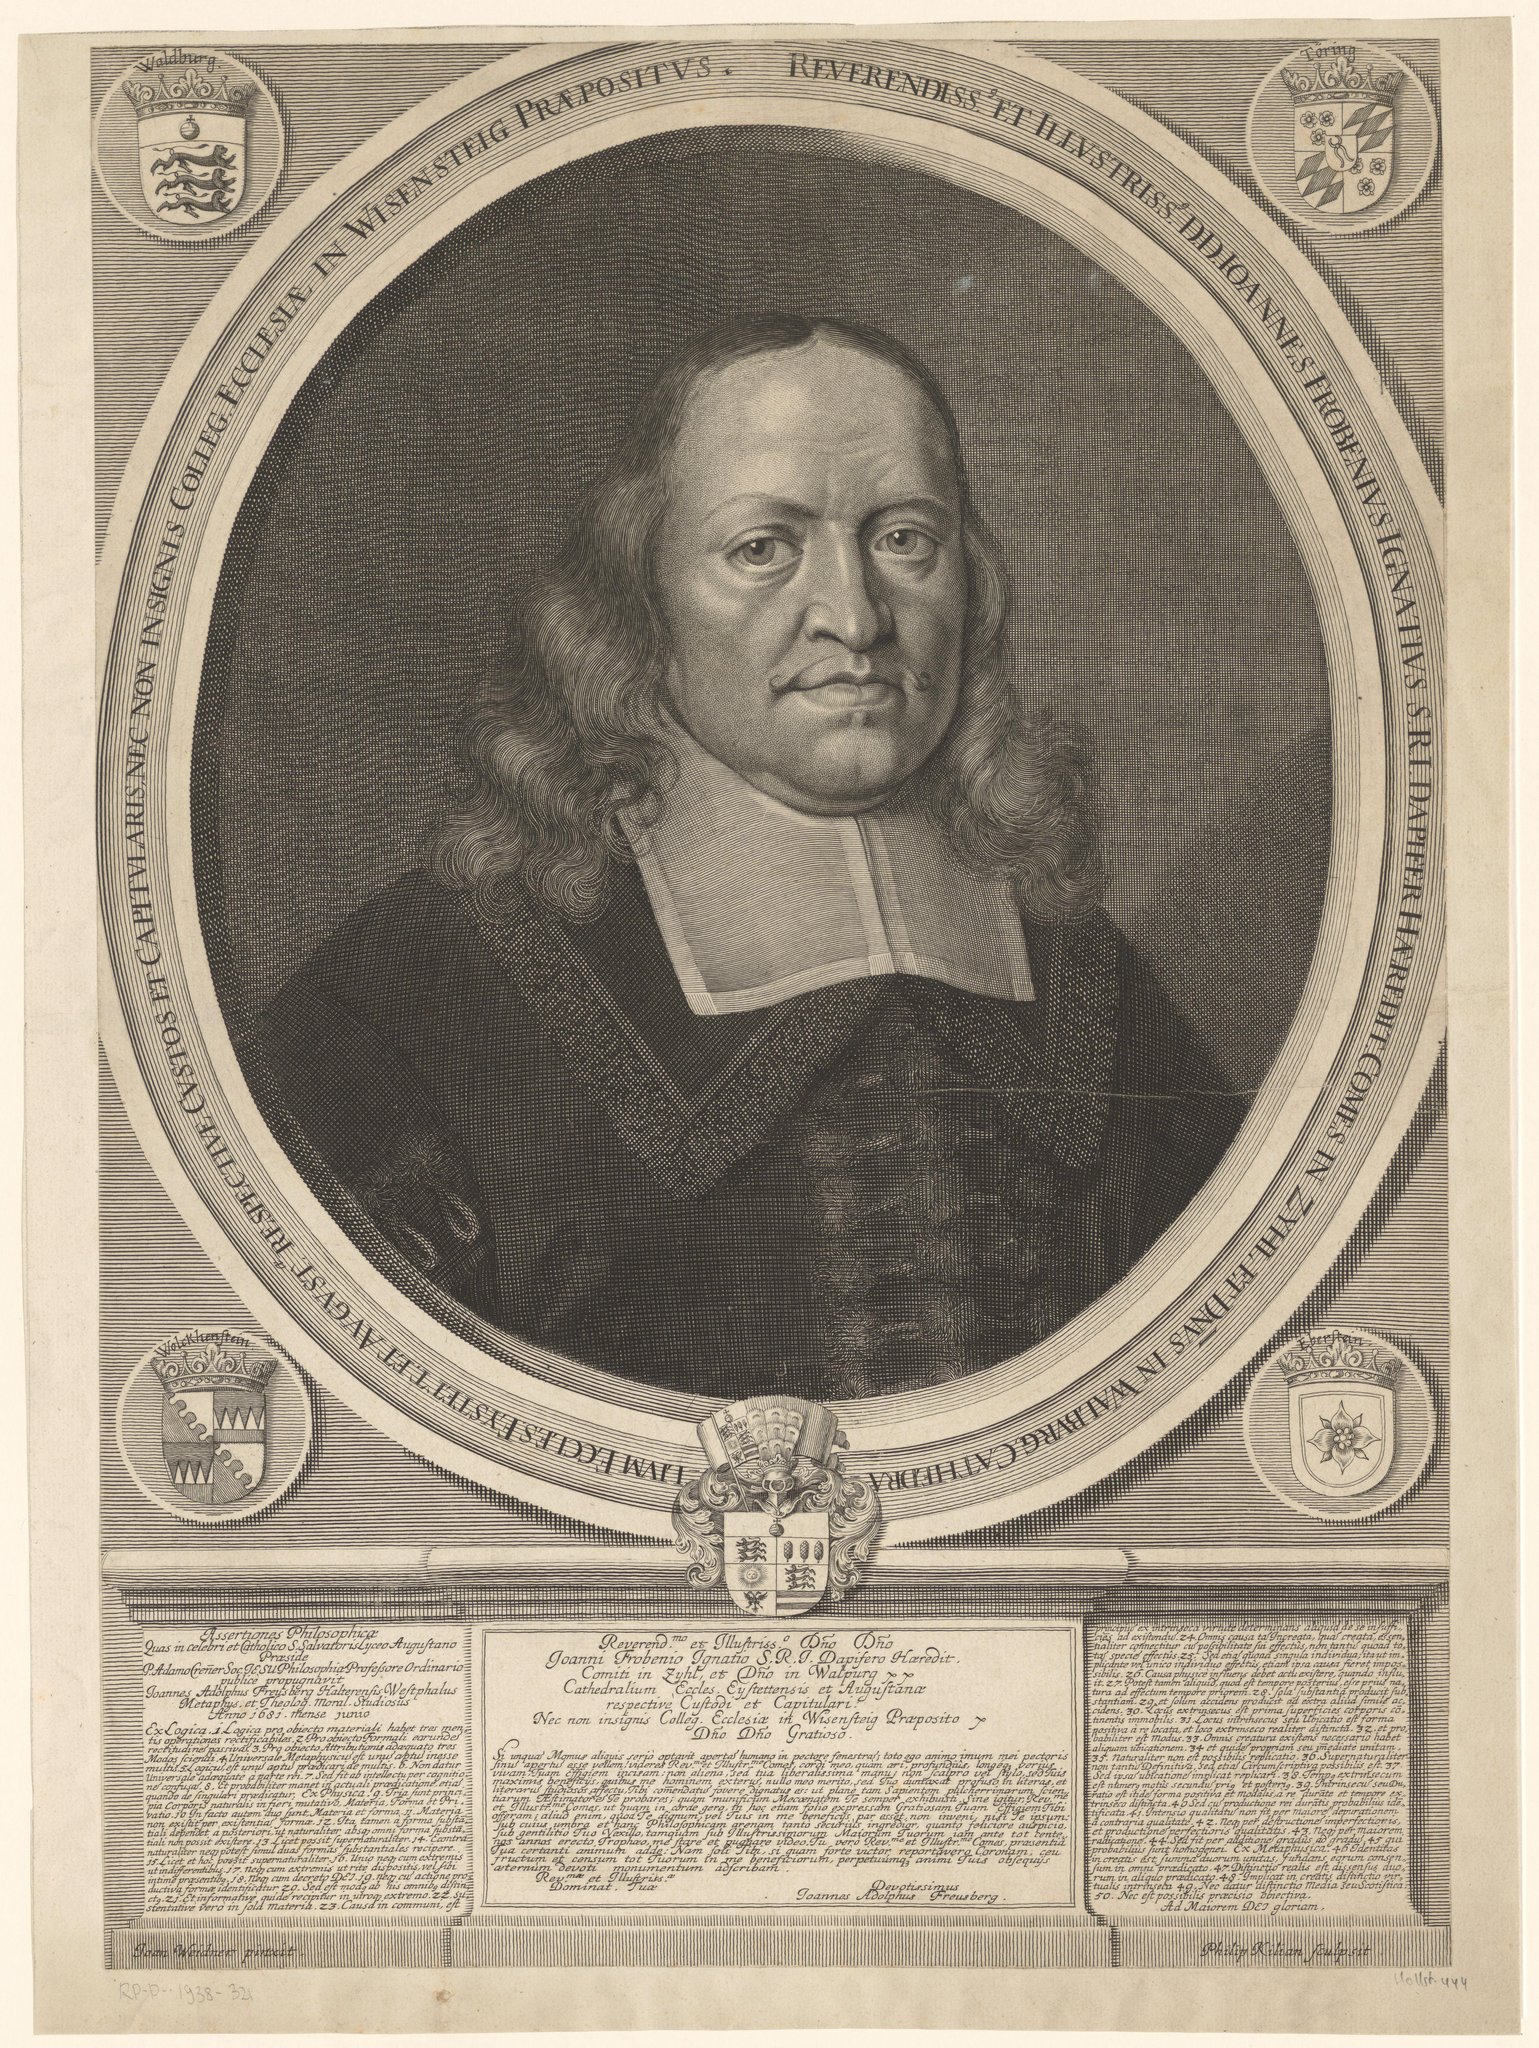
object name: print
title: Portret van Johann Froben Ignatius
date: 1681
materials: paper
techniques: engraving, etching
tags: johann froben ignatius (graaf van waldburg-zeil), historical persons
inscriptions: collector's mark: Lugt 2228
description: Tekst in het Latijn in de omlijsting en in de ondermarge.